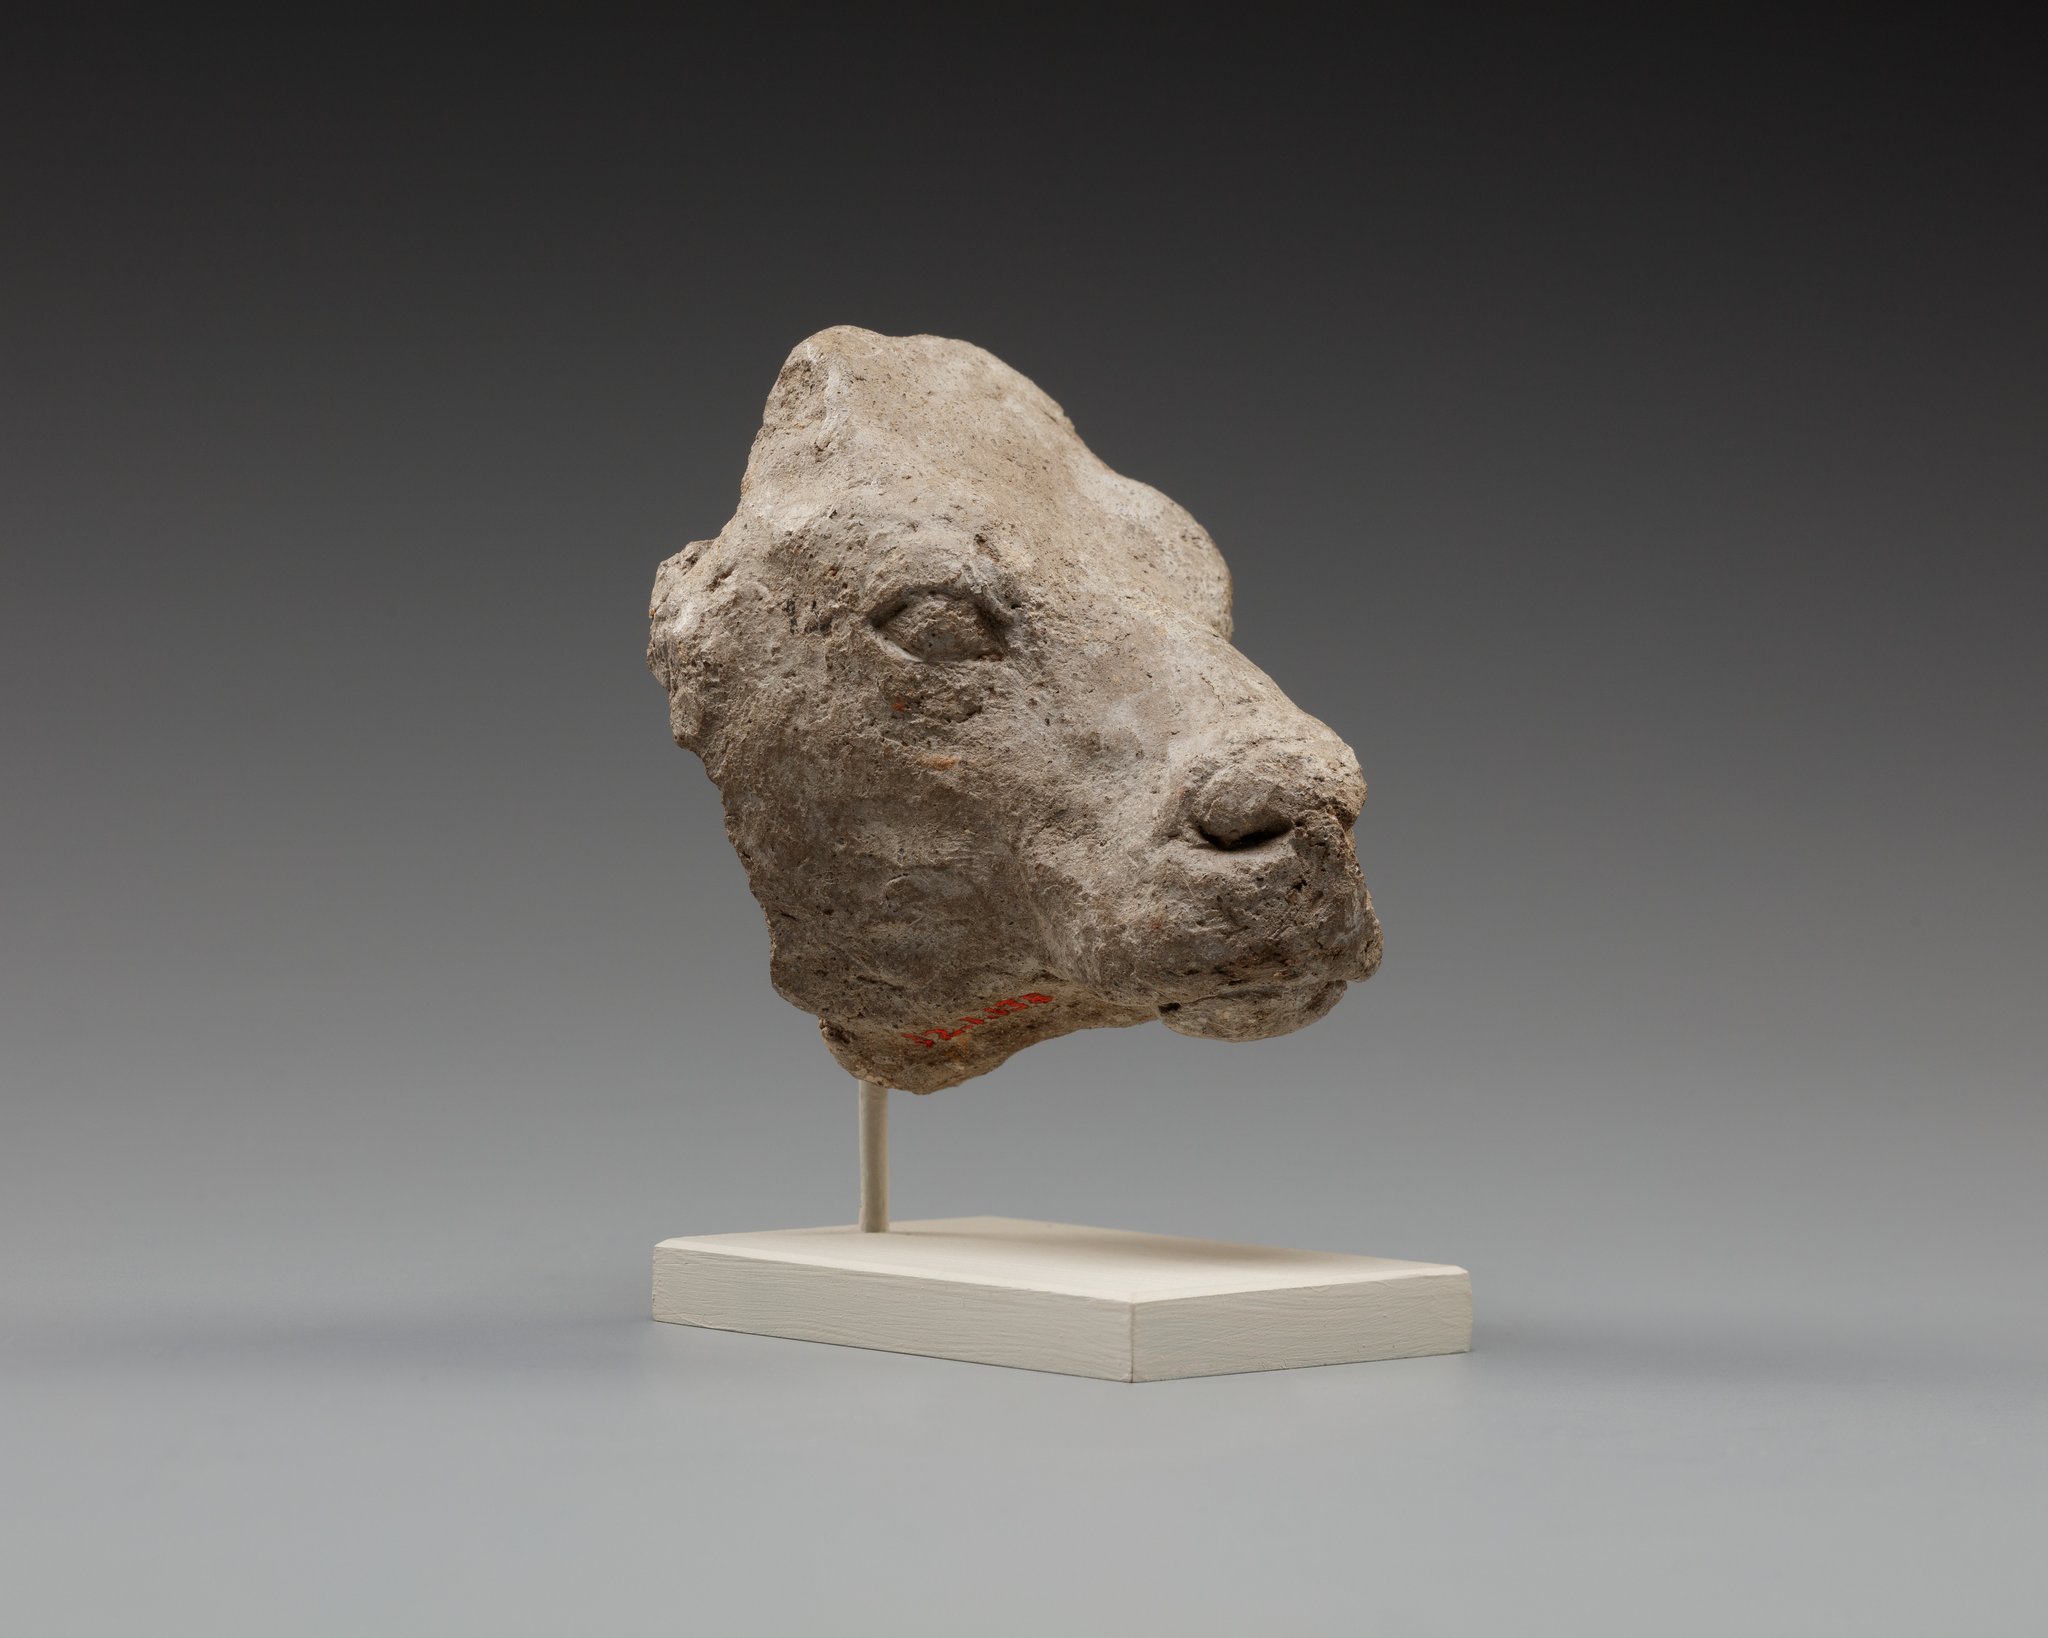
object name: figurine, calf's head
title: Calf's head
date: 1981-1640 BCE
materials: clay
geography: egypt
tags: animals